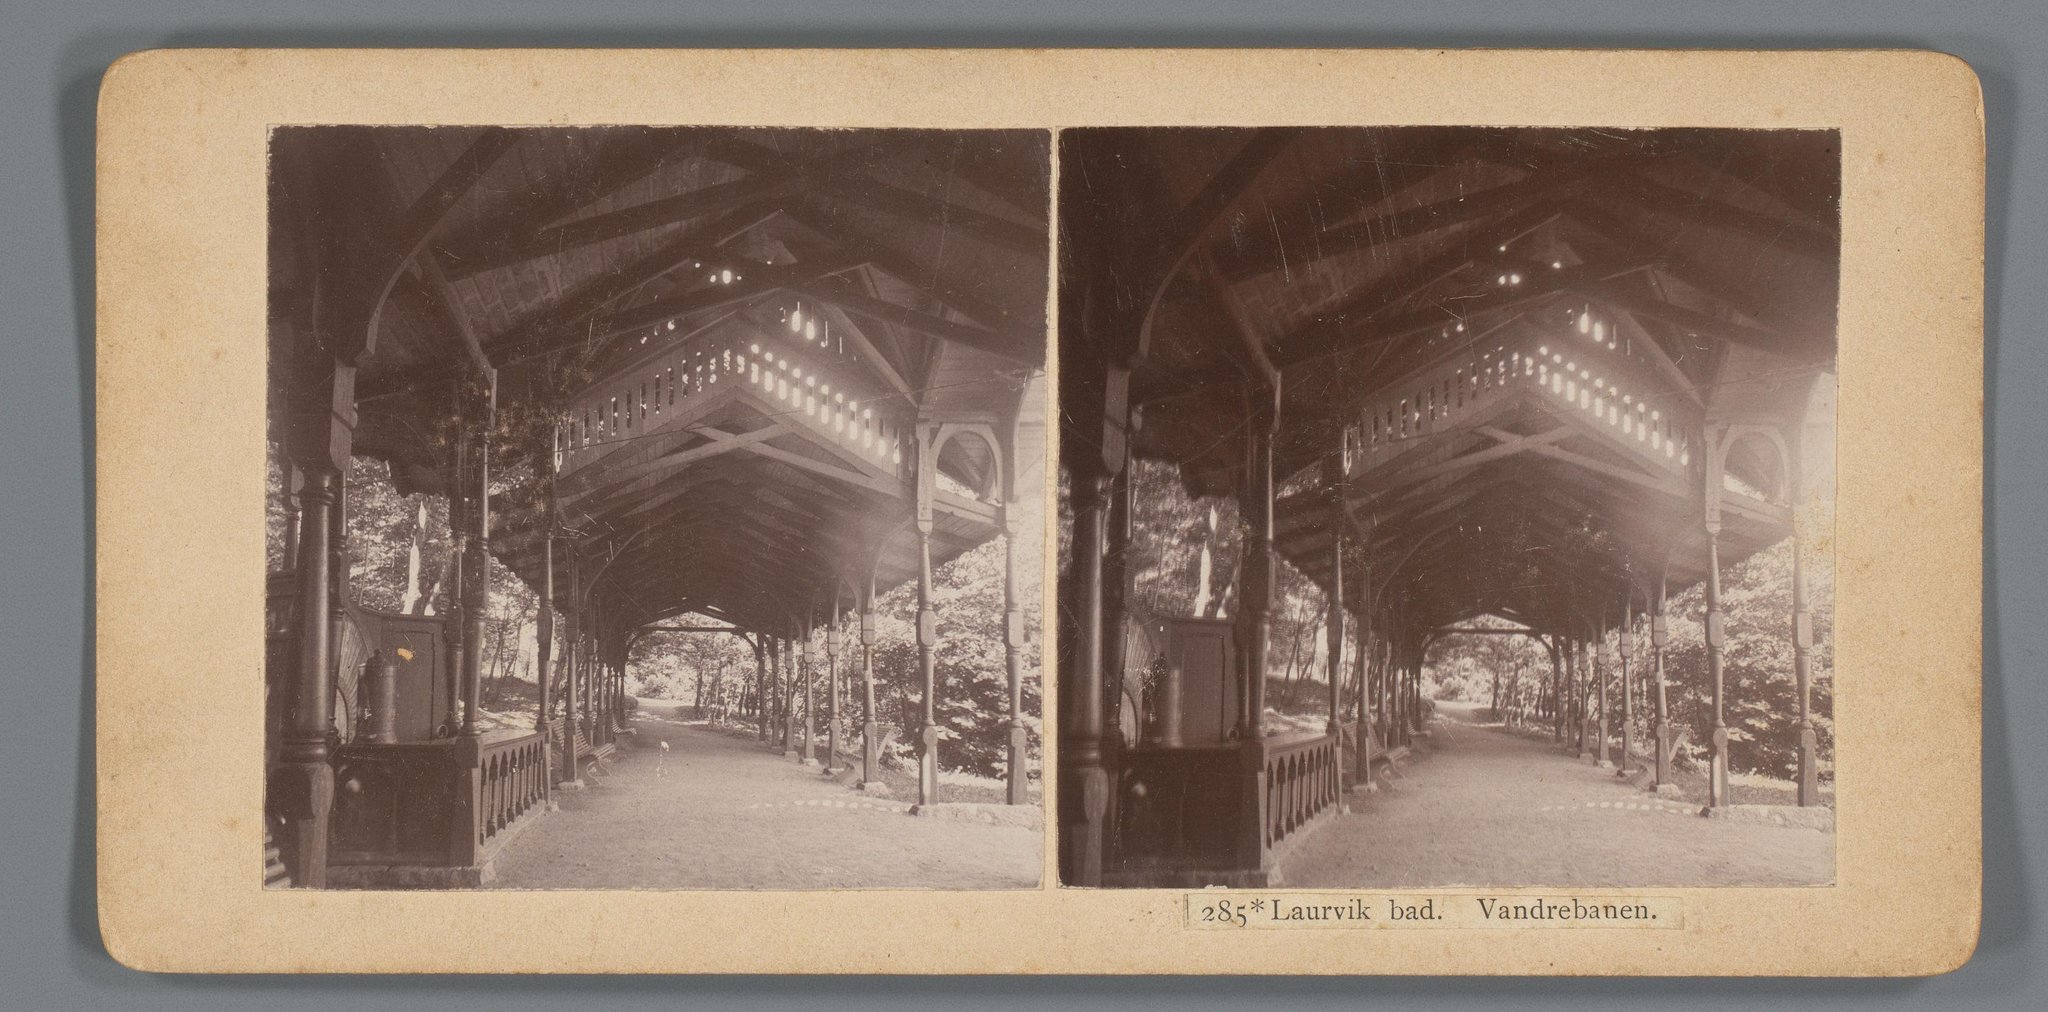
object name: stereograph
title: Laurvik bad. Vandrebanen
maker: severin worm-petersen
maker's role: fotograaf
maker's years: 1857-1933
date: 1876-1889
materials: cardboard, photographic support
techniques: collodion silver print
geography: larvik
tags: forest path or lane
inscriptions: inscription: ‘Noorwegen’, stamp: ‘JAC MOULIN/ DEN HAAG’, number: ‘285*’